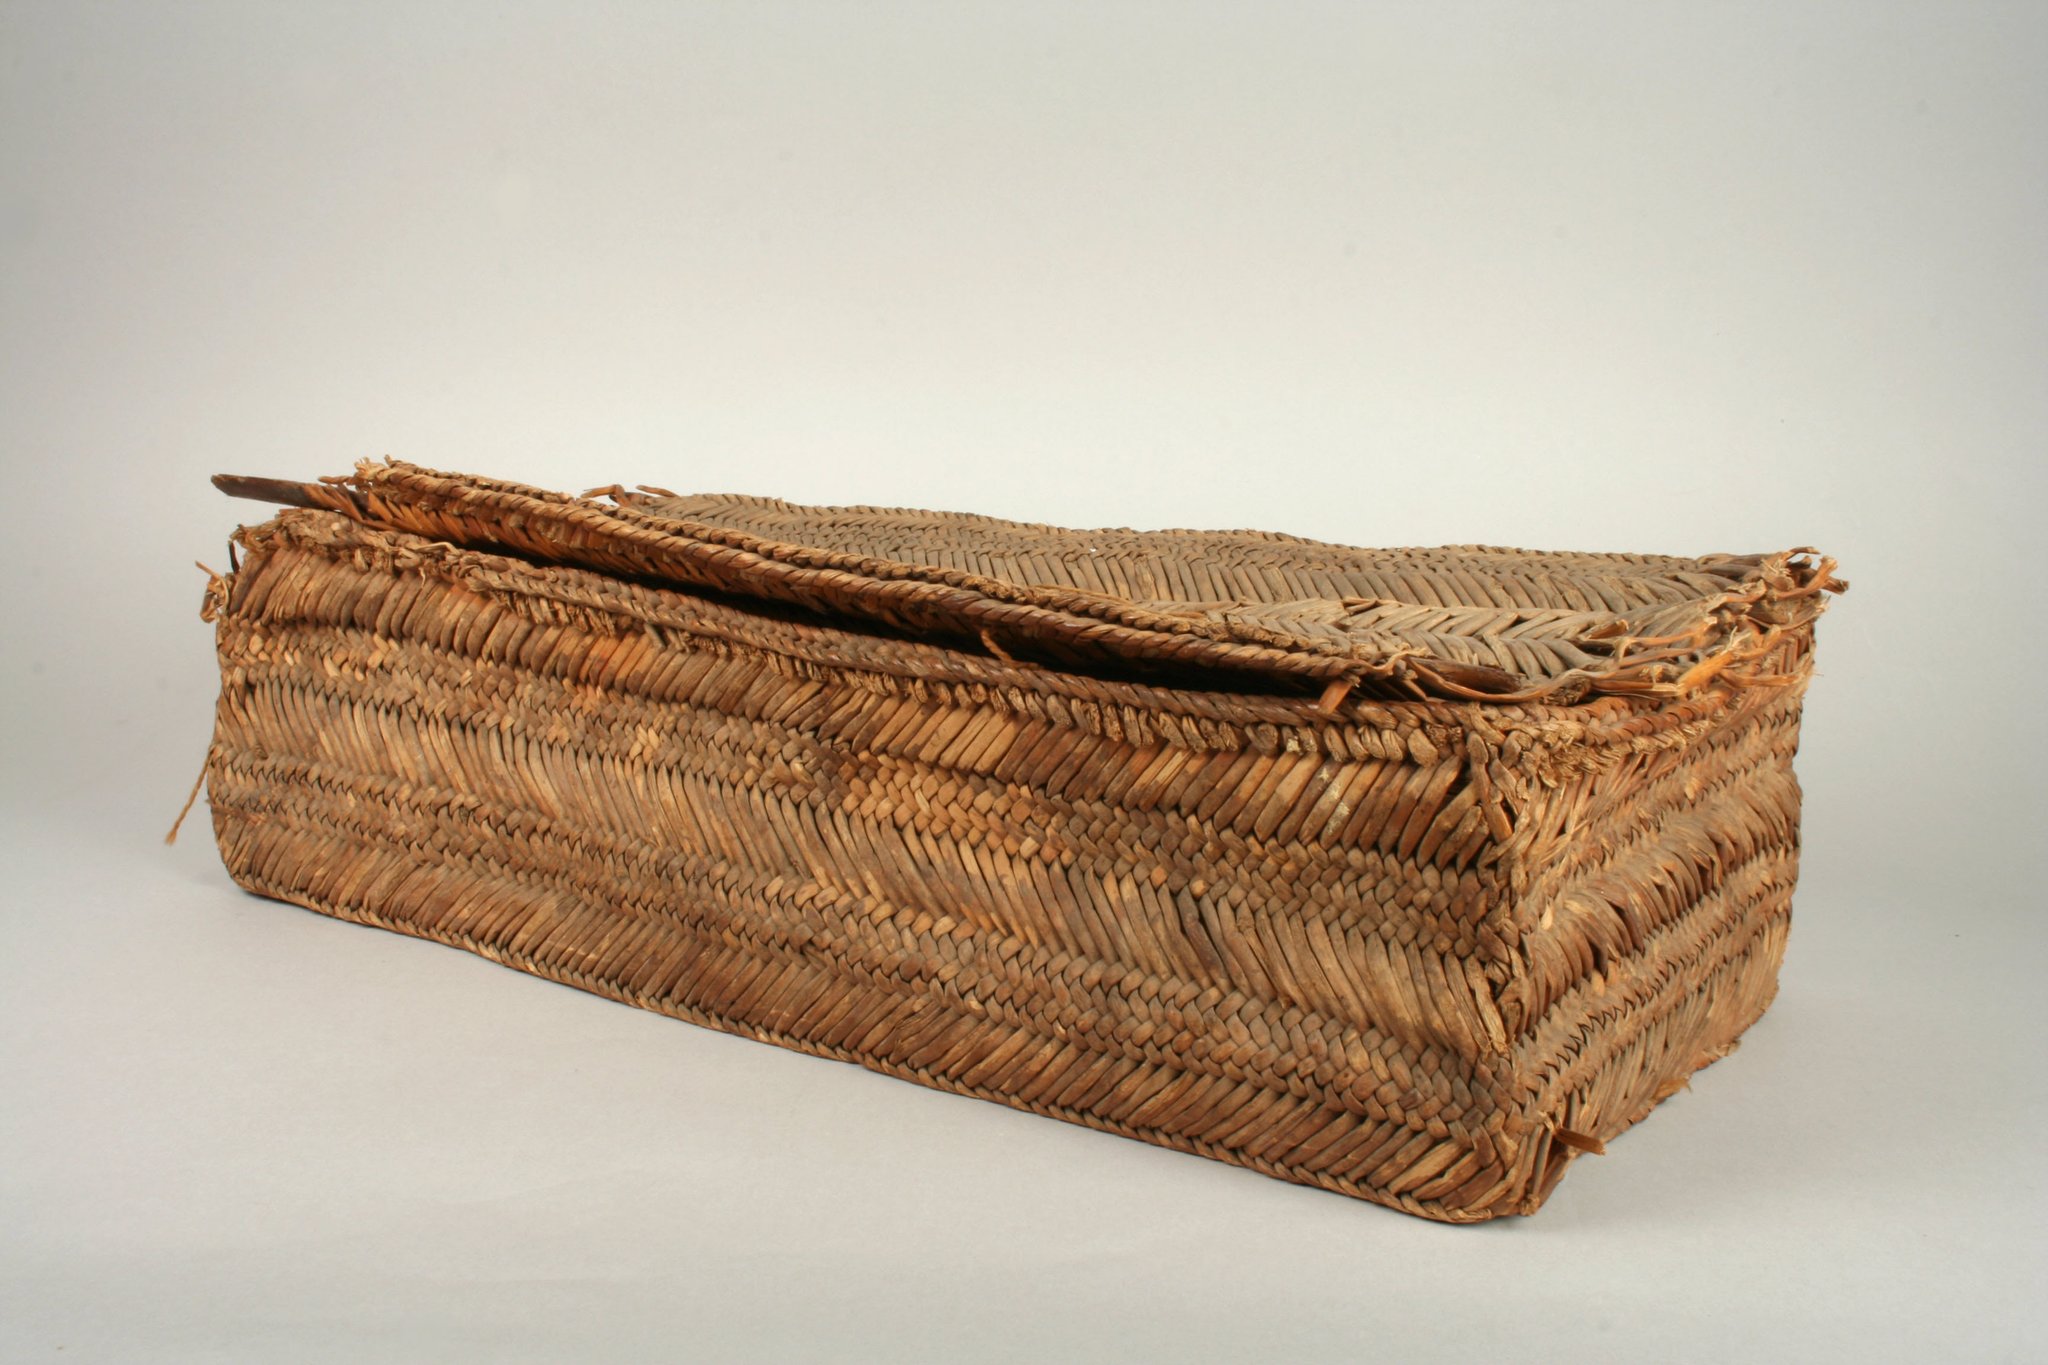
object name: basket with weaving implement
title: Weaving Basket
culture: chancay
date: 1101-1400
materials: bone, animal fiber, fiber, metal, pigment, shell, stone, wood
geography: peru